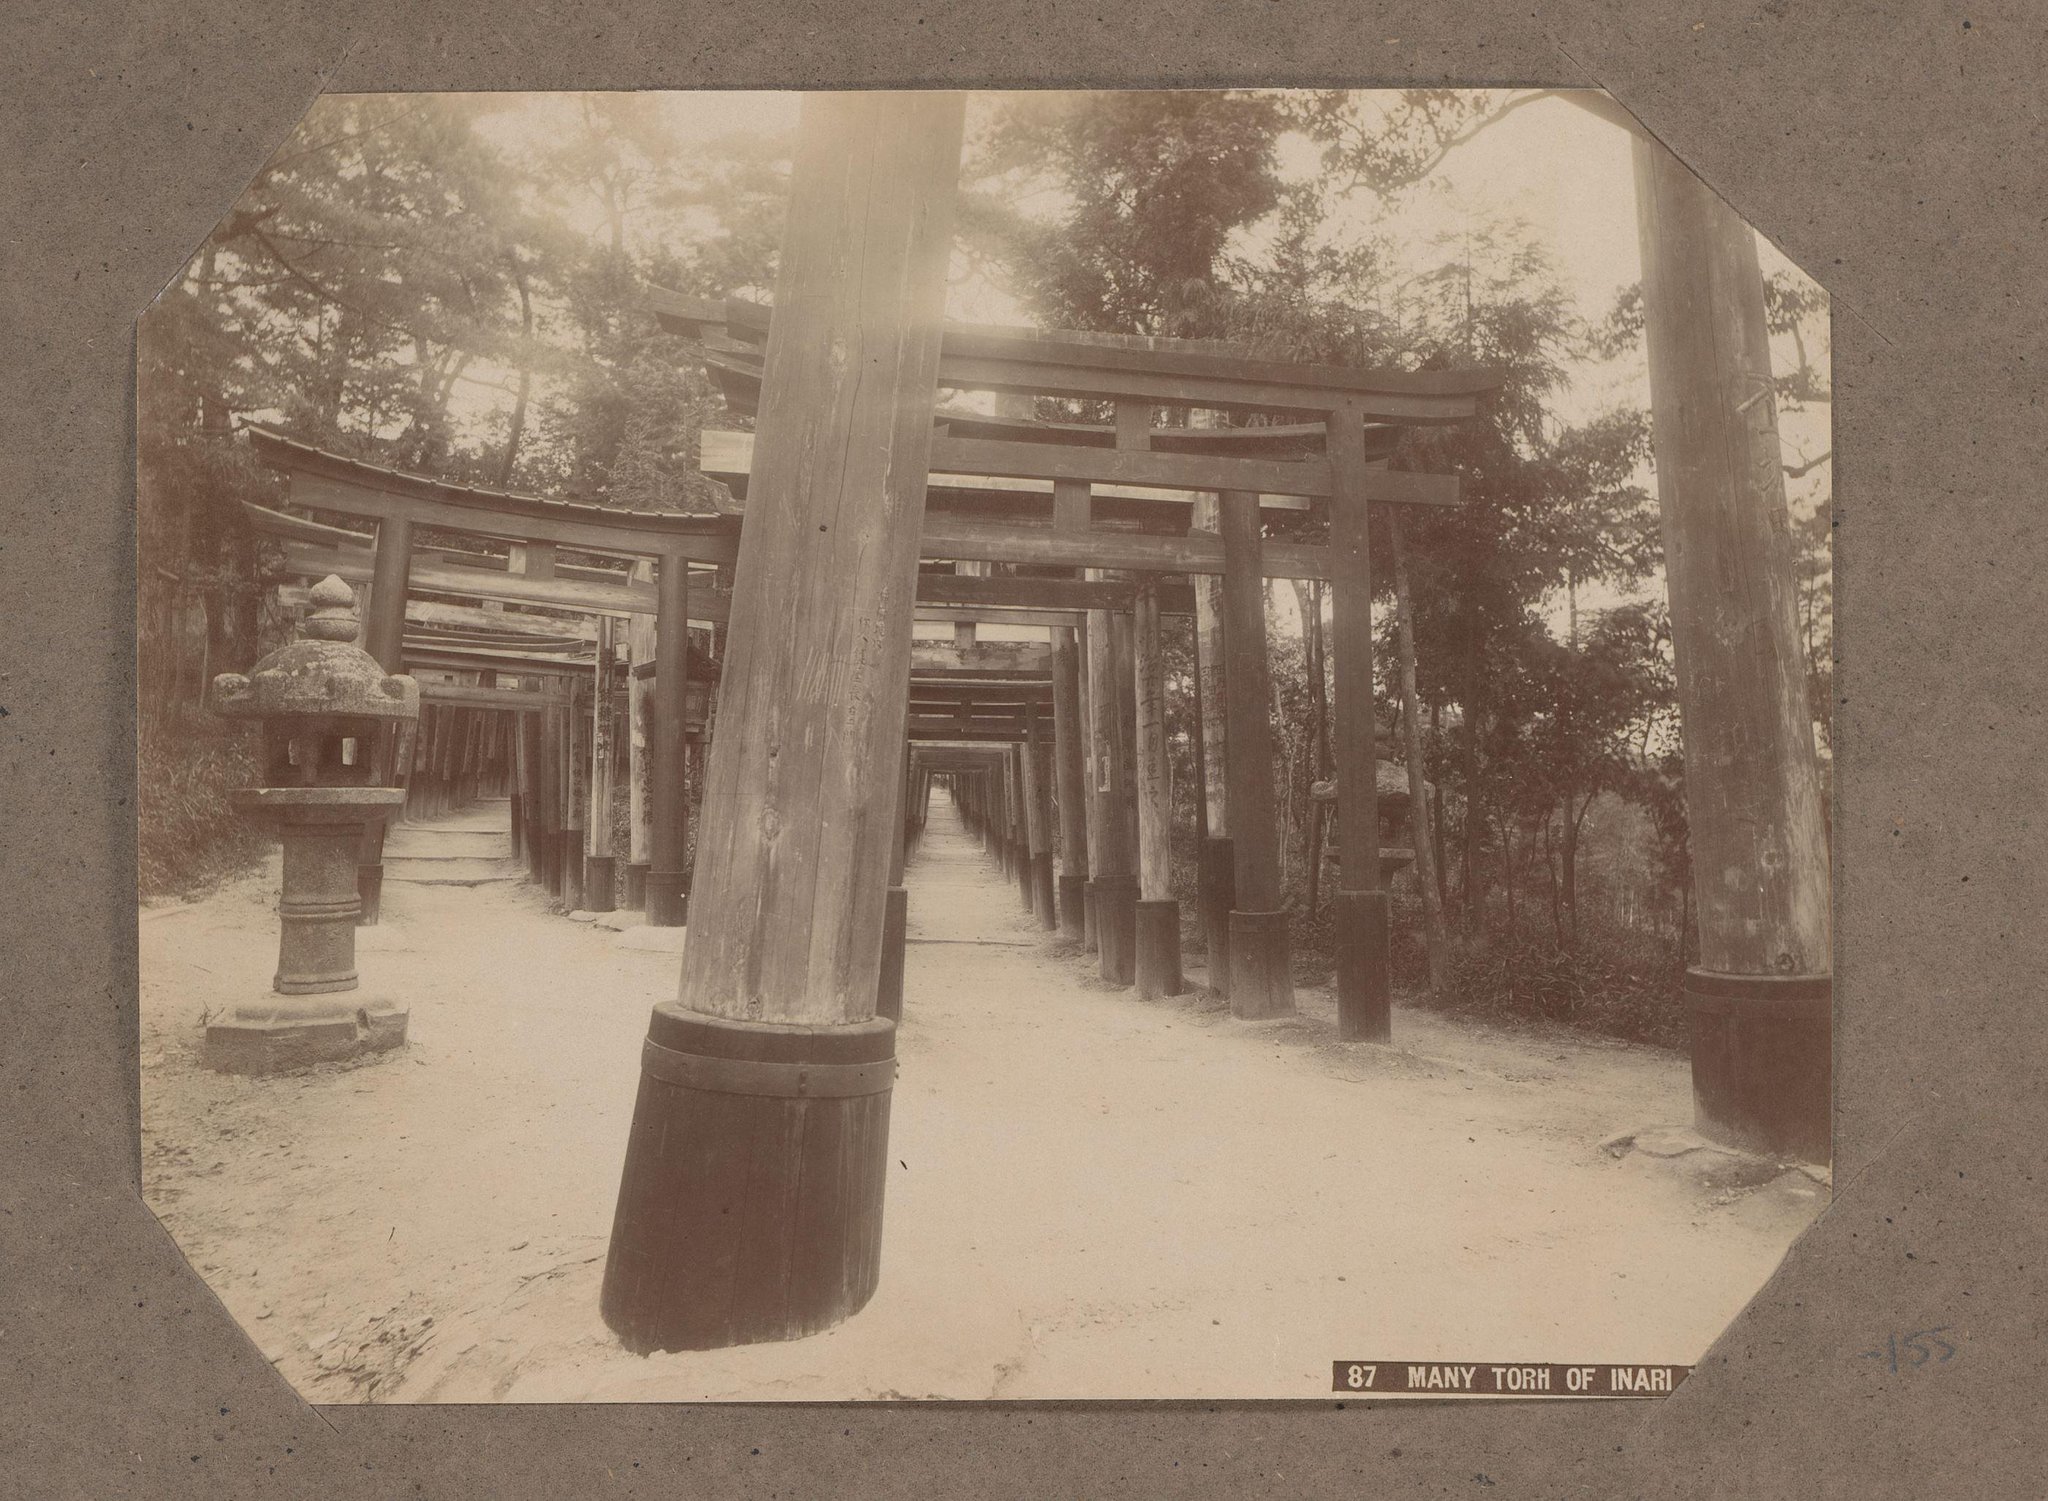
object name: photograph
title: Twee Torii-galerijen van het Fushimi Inari-taisha tempelcomplex in Kyoto, Japan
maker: Anonymous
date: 1890-1903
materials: paper, photographic support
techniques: albumen print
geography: kyoto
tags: temple, shrine ~ shinto, architectural detail, kyoto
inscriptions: inscription: ‘87 Many Torh of Inari Te[m]ple Kioto’